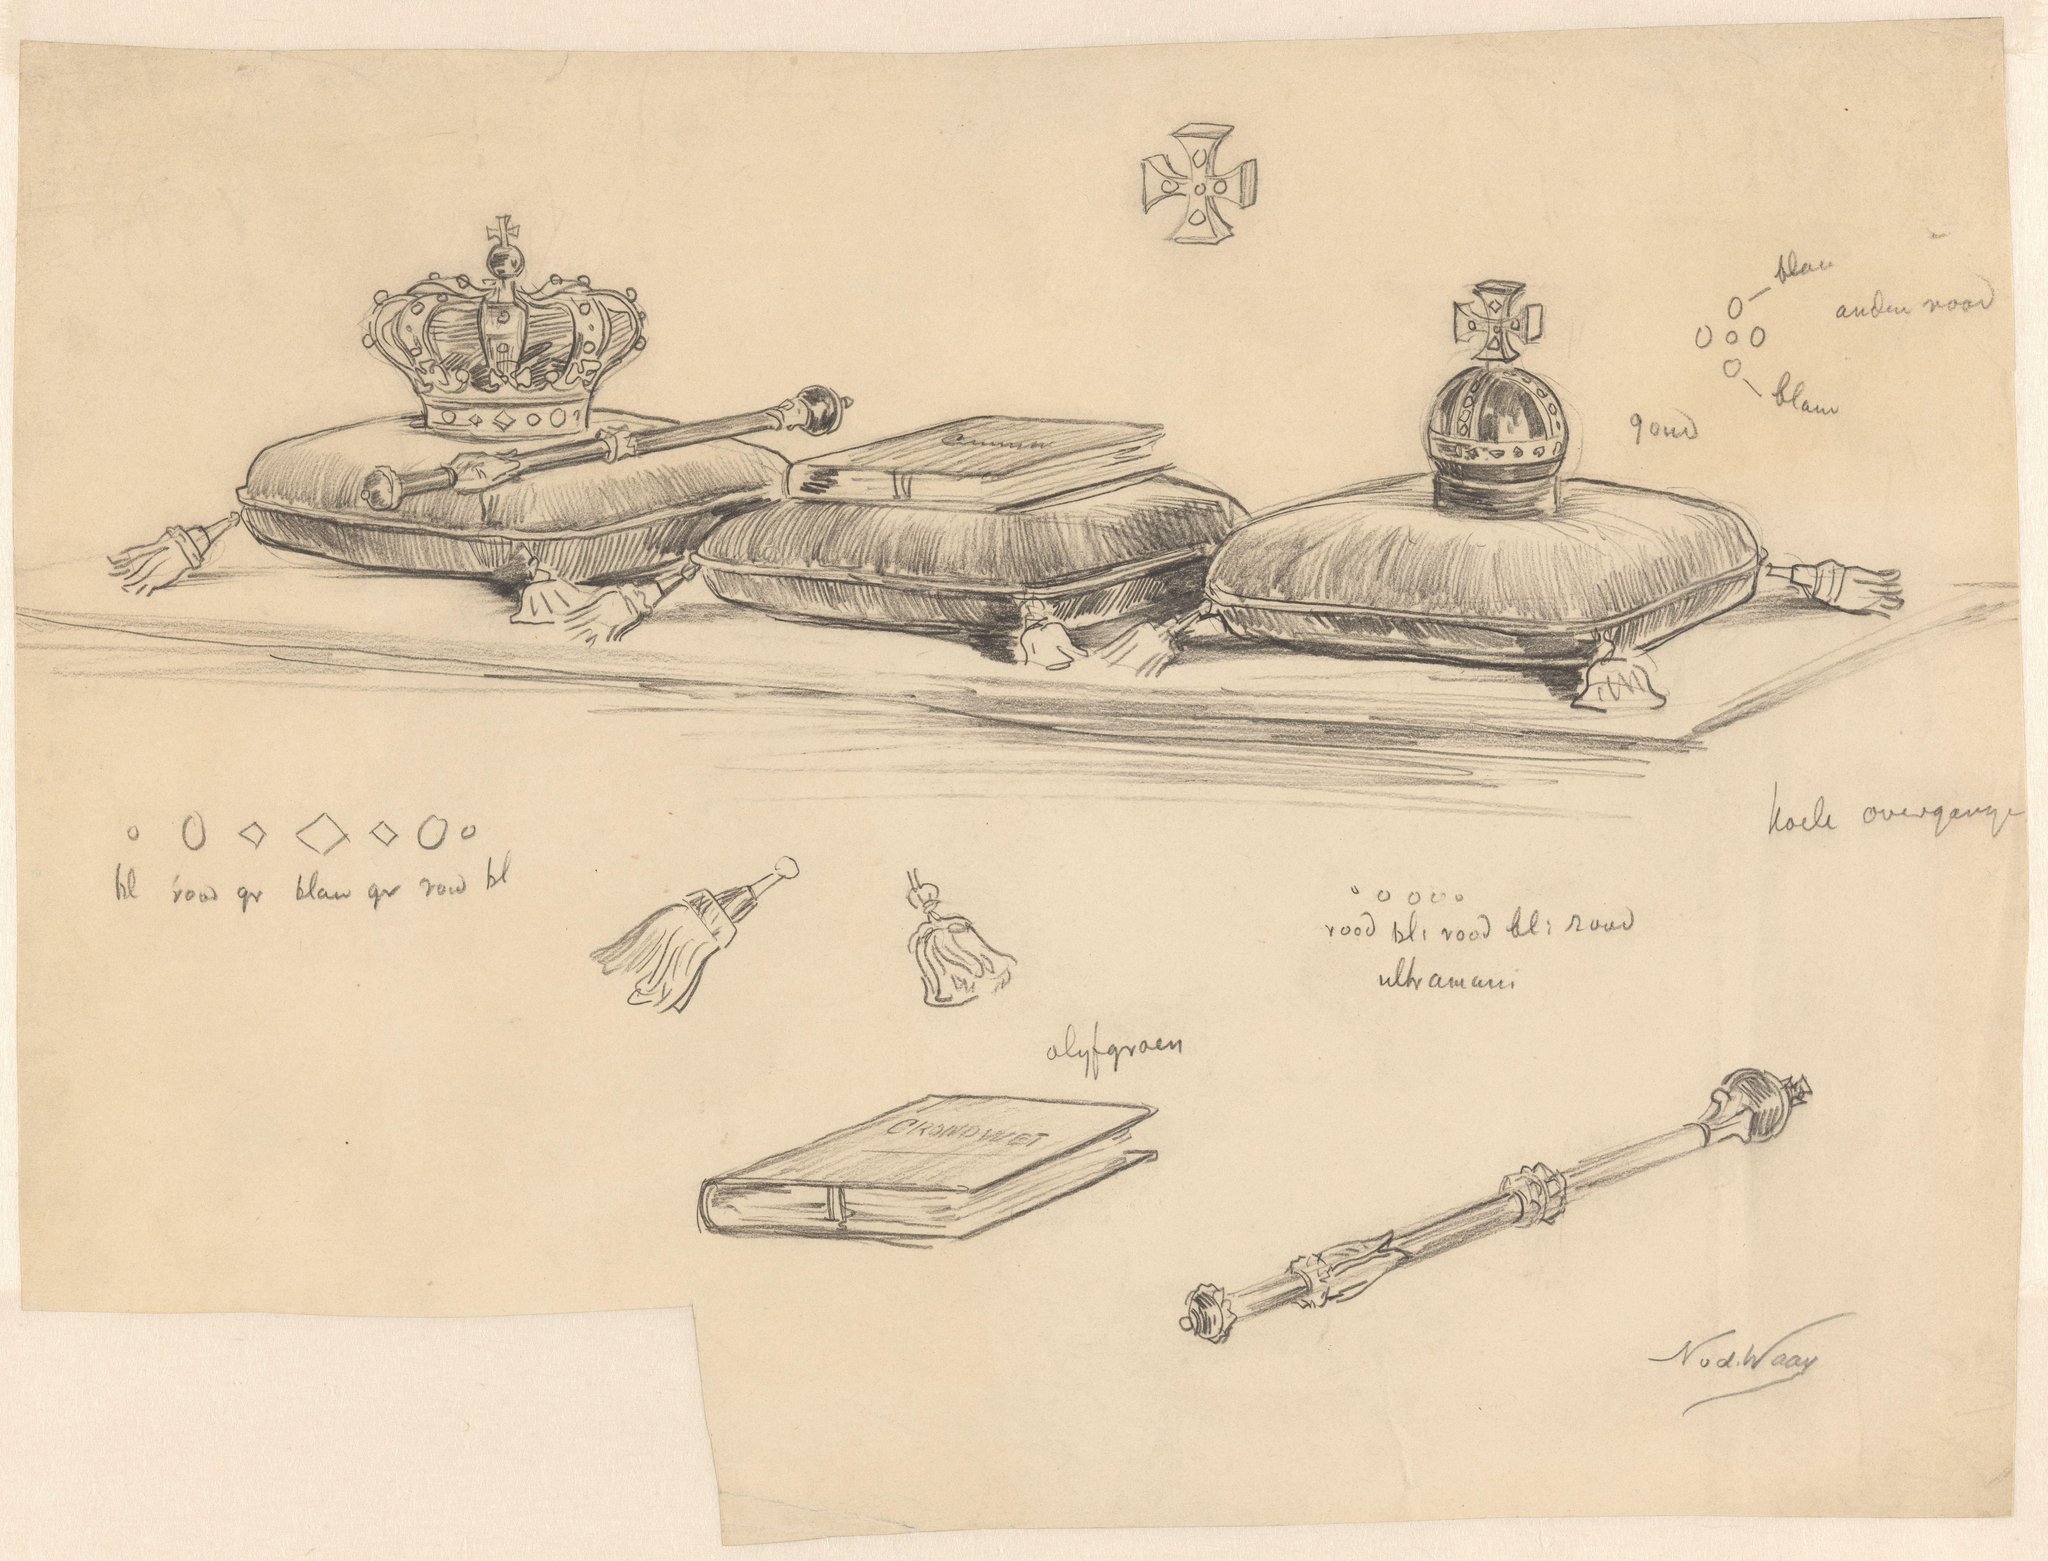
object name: drawing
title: Kussens met kroon, scepter, grondwet en rijksappel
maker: nicolaas van der waay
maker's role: draughtsman, painter, print maker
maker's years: 1855-1936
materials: chalk, paper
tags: crown (symbol of sovereignty), orb (symbol of sovereignty; sphere with cross on top), sceptre, staff (symbol of sovereignty)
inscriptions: number: ‘971’, collector's mark: Lugt 2760, annotation: ‘[...]J 159/30’, collector's mark: Lugt 2228, :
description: Studie voor het schilderij dat Nicolaas van der Waay maakte van de inhuldiging van Wilhelmina als koningin der Nederlanden in 1898. Op het schilderij liggen de voorwerpen in exact dezelfde volgorde op een tafel.